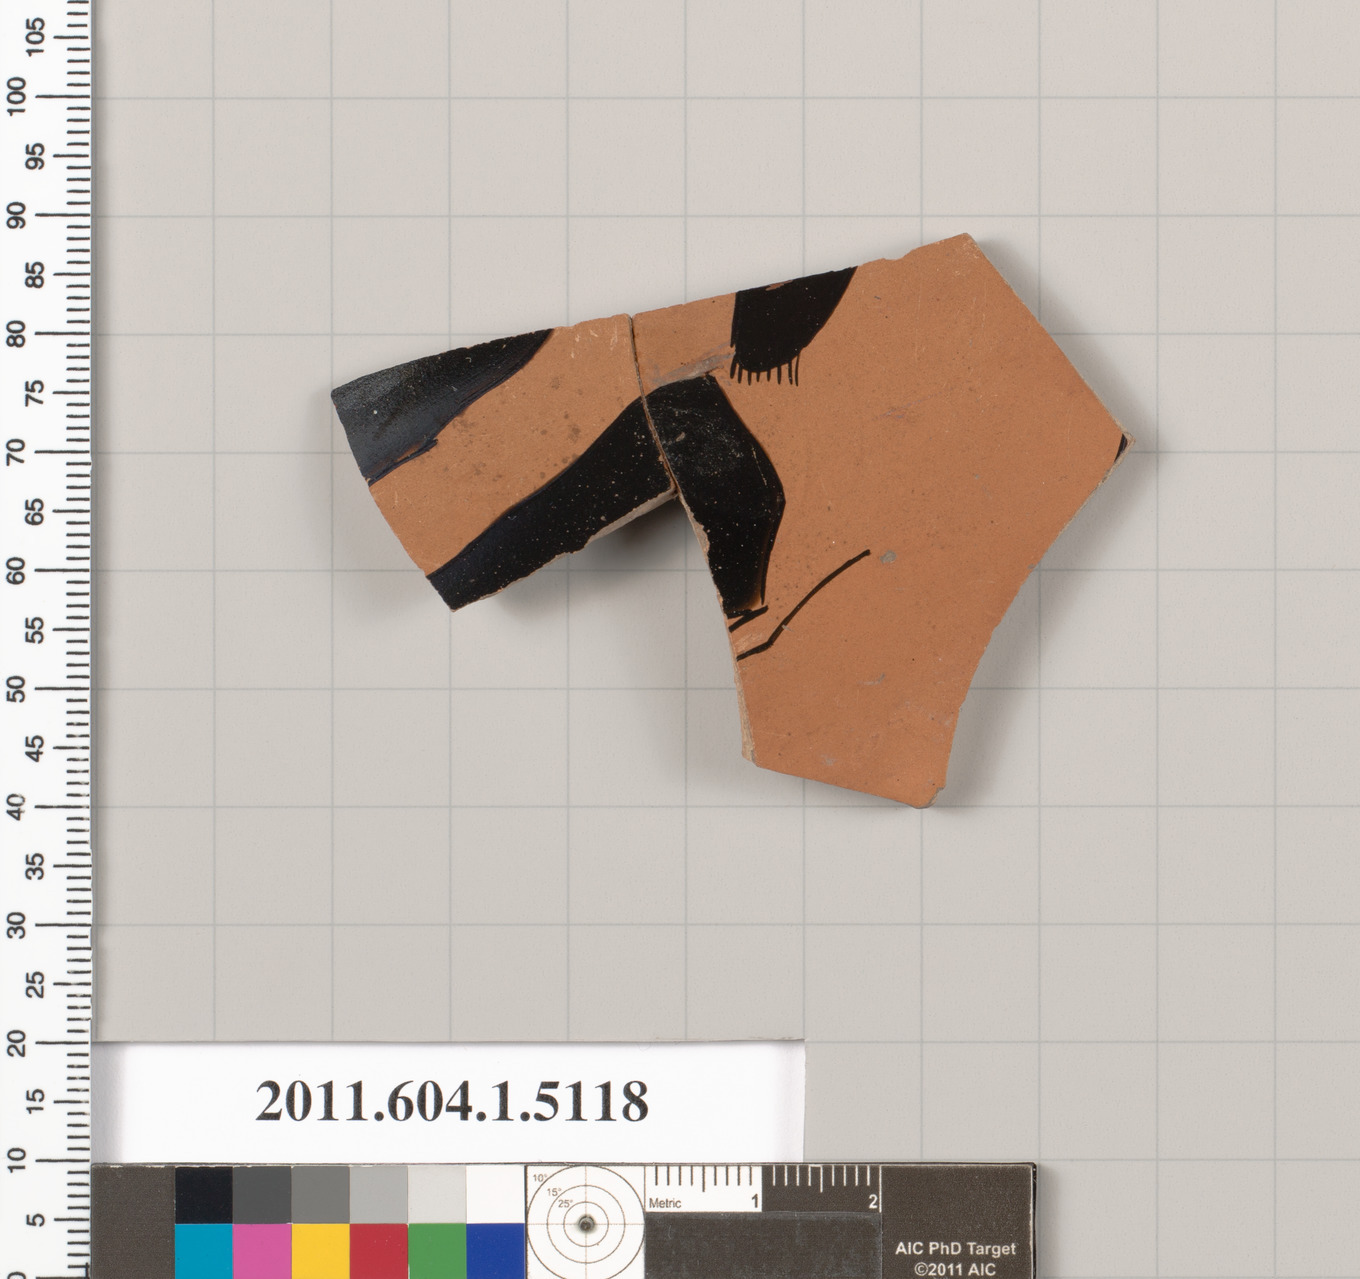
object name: kylix fragment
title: Terracotta fragment of a kylix (drinking cup)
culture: greek, attic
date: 534-468 BCE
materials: terracotta